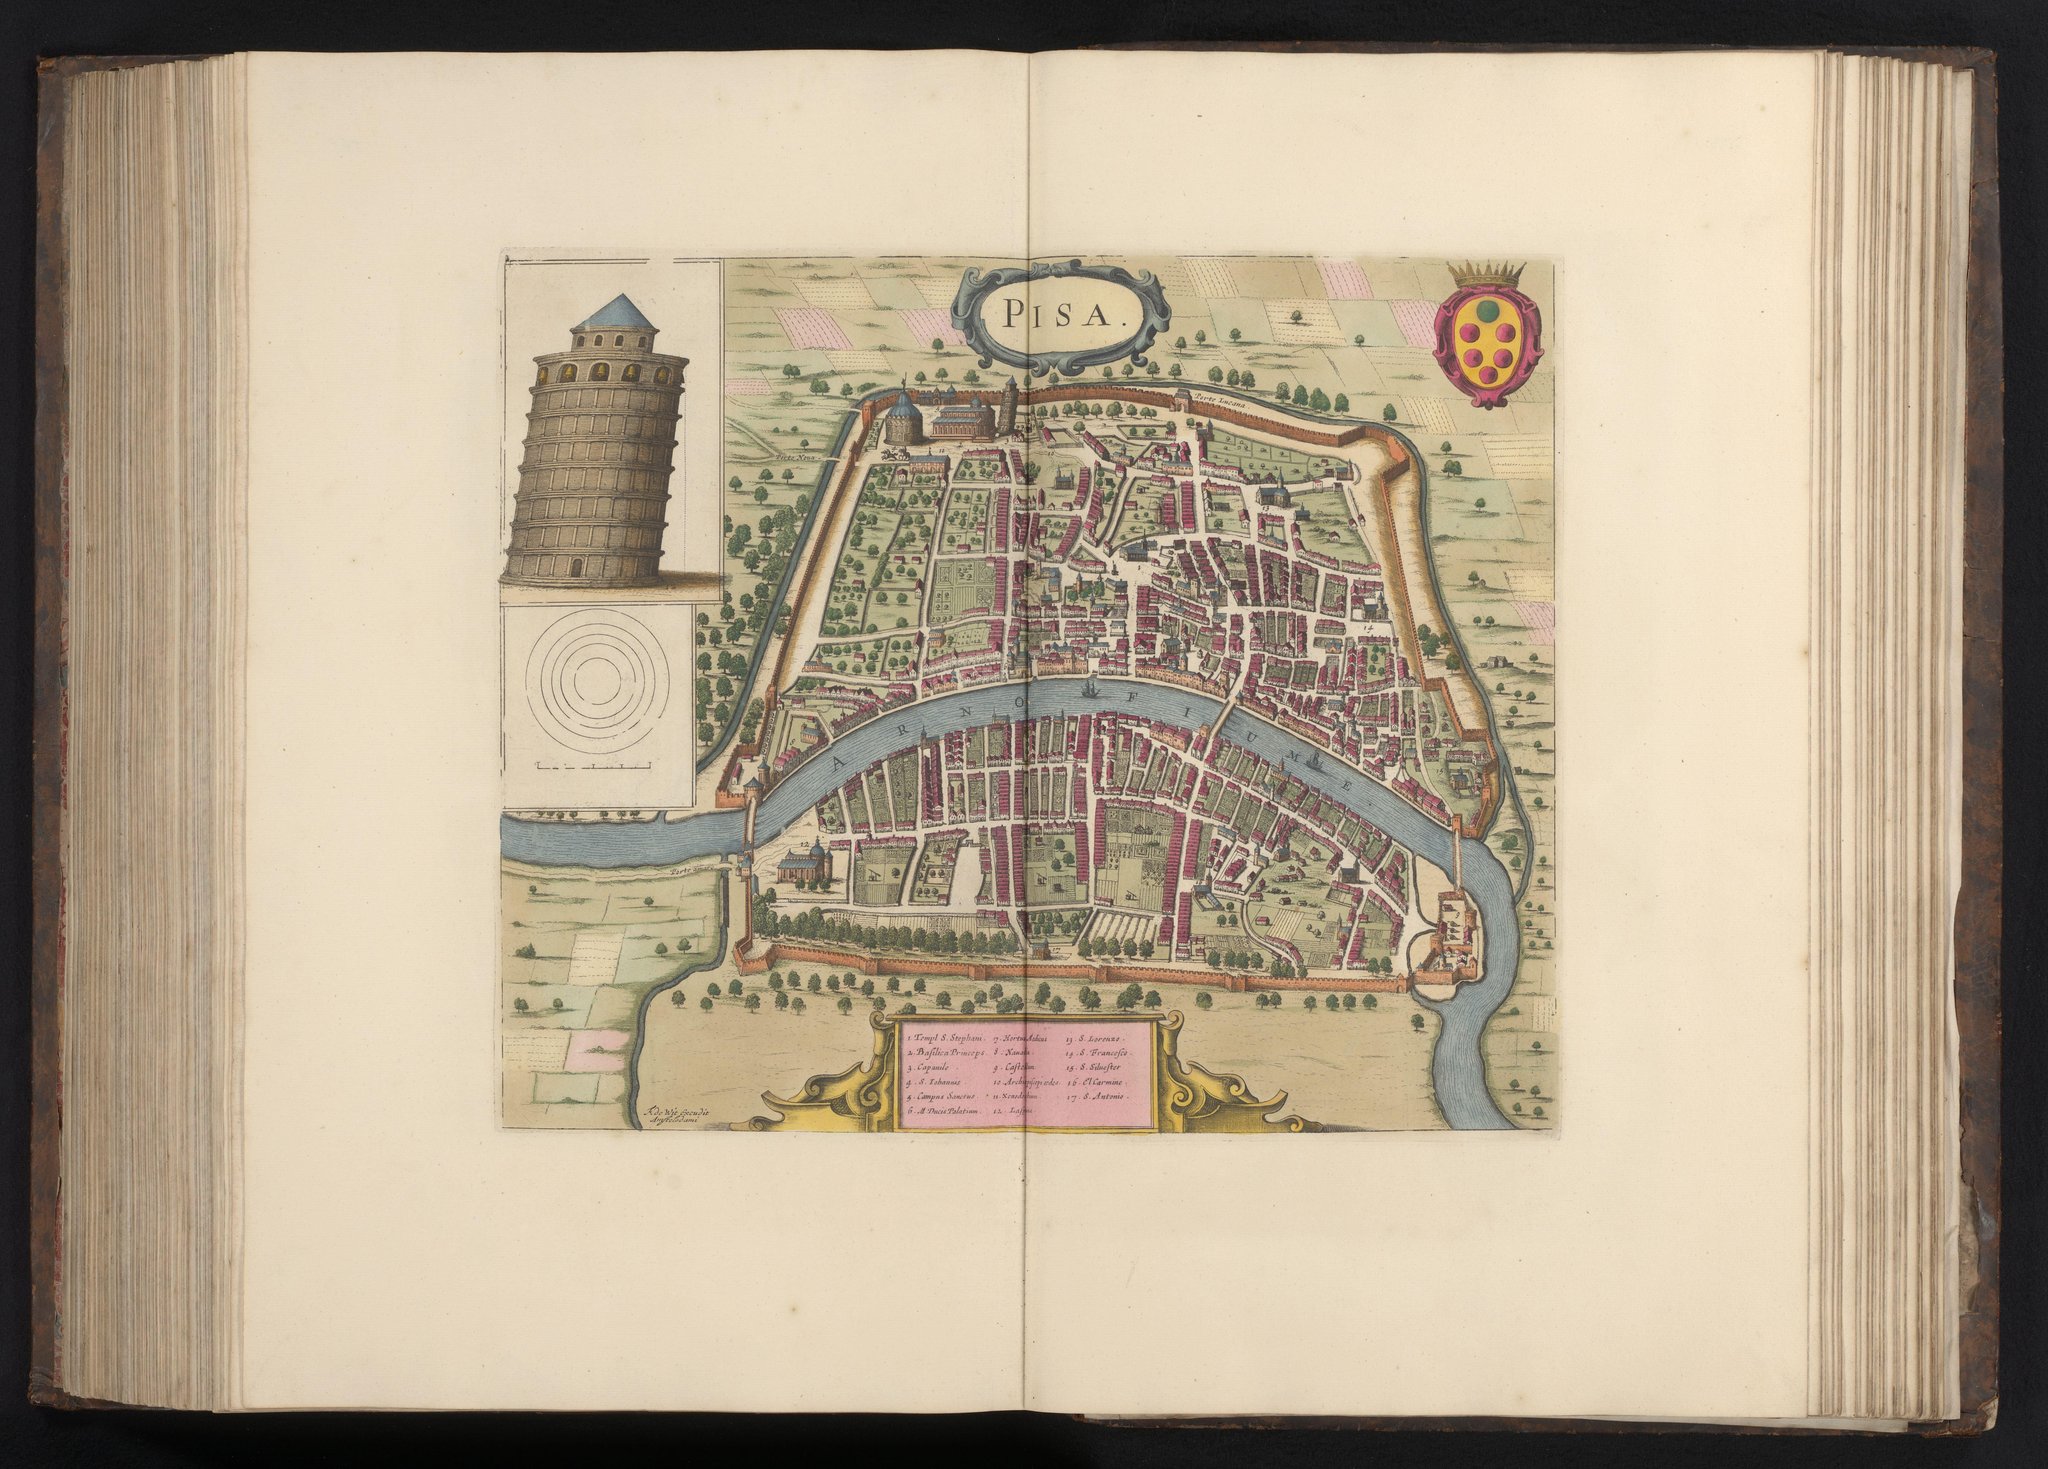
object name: album leaf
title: Gezicht op Pisa in vogelvluchtperspectief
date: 1617-1677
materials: paper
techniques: colour, etching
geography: amsterdam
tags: coat of arms (symbol of sovereignty), bird's eye view ~ architectural design or model, maps of cities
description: Gezicht op Pisa in vogelvluchtperspectief. Linksboven twee voorstellingen van de opstand en de doorsnede van de Toren van Pisa. Rechtsboven het wapen van de familie De'Medici. Midden onder een verklarende lijst met nummers. Prent maakt deel uit van een album.